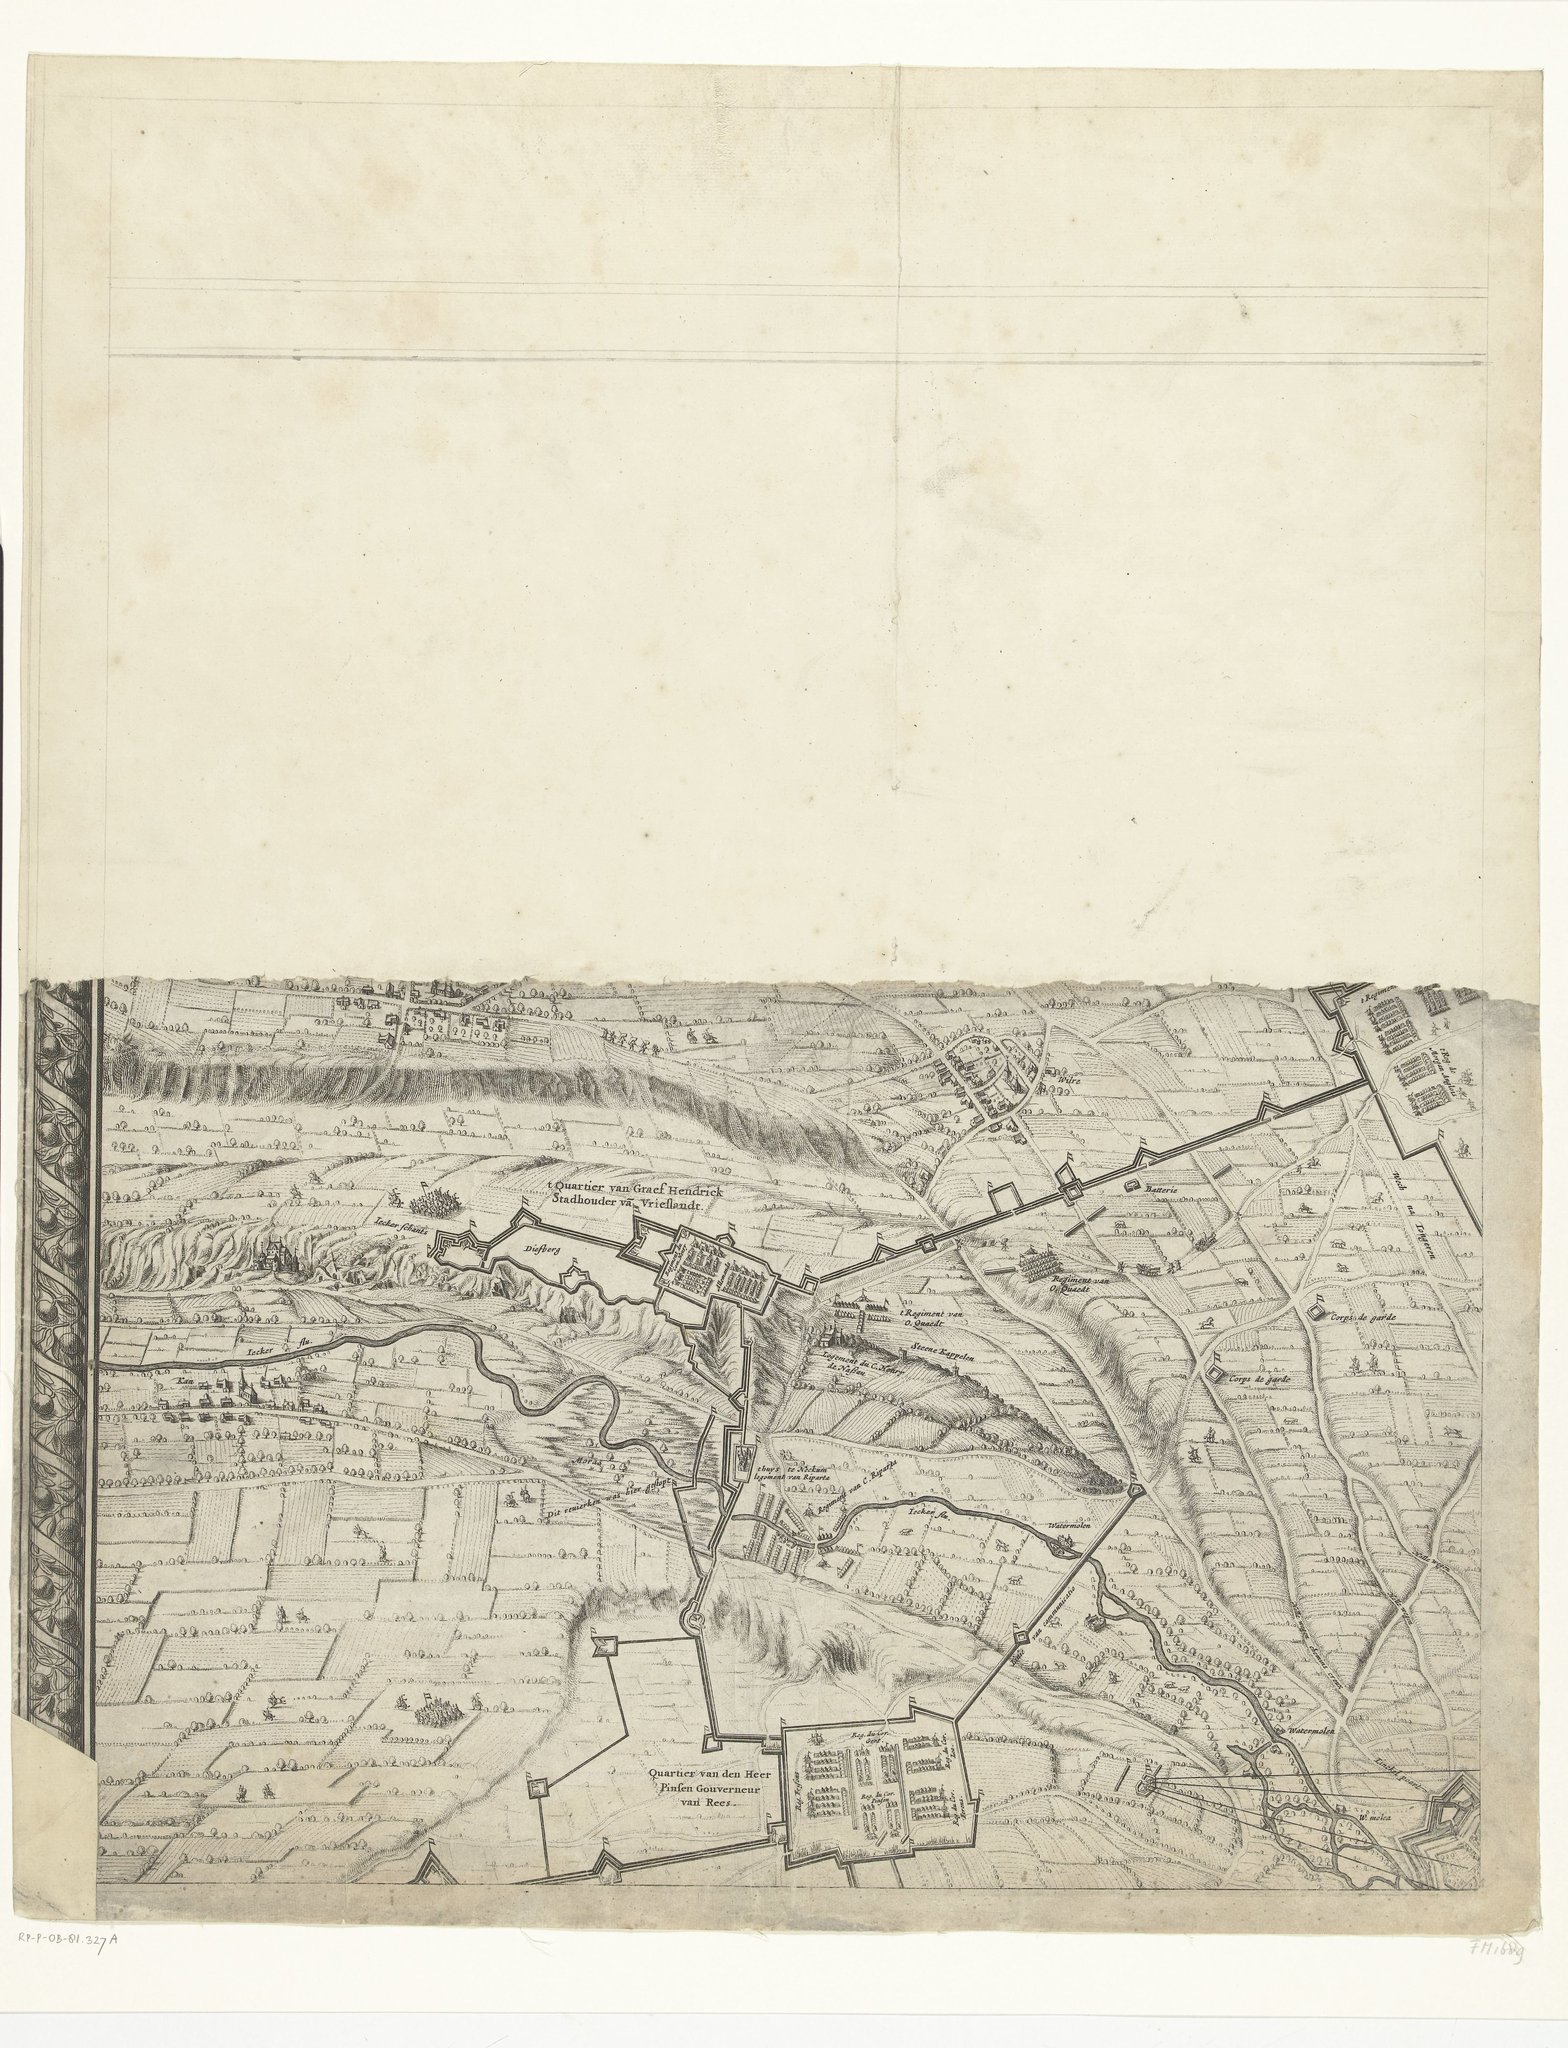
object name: map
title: Grote kaart van het beleg van Maastricht, 1632, plaat 1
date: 1632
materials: paper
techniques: etching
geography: northern netherlands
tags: delft, frederick henry (prince of orange), arnhem, hendrik casimir i graaf van nassau-dietz, maps of separate countries or regions, siege, position war, maastricht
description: Grote kaart van het beleg en de inname van Maastricht door het Staatse leger onder stadhouder Frederik Hendrik, 9 juni tot 21 augustus 1632. Kaart samengesteld uit zes bladen, drie boven en drie beneden (het zesde blad rechtsonder ontbreekt). Dit is het eerste blad linksboven. De bovenste helft van dit blad ontbreekt. Met de legerkampen van kolonel Pinsen van der Aa en Hendrik Casimir I van Nassau-Dietz, stadhouder van Friesland. Met opschriften in de voorstelling in het Frans en Nederlands.